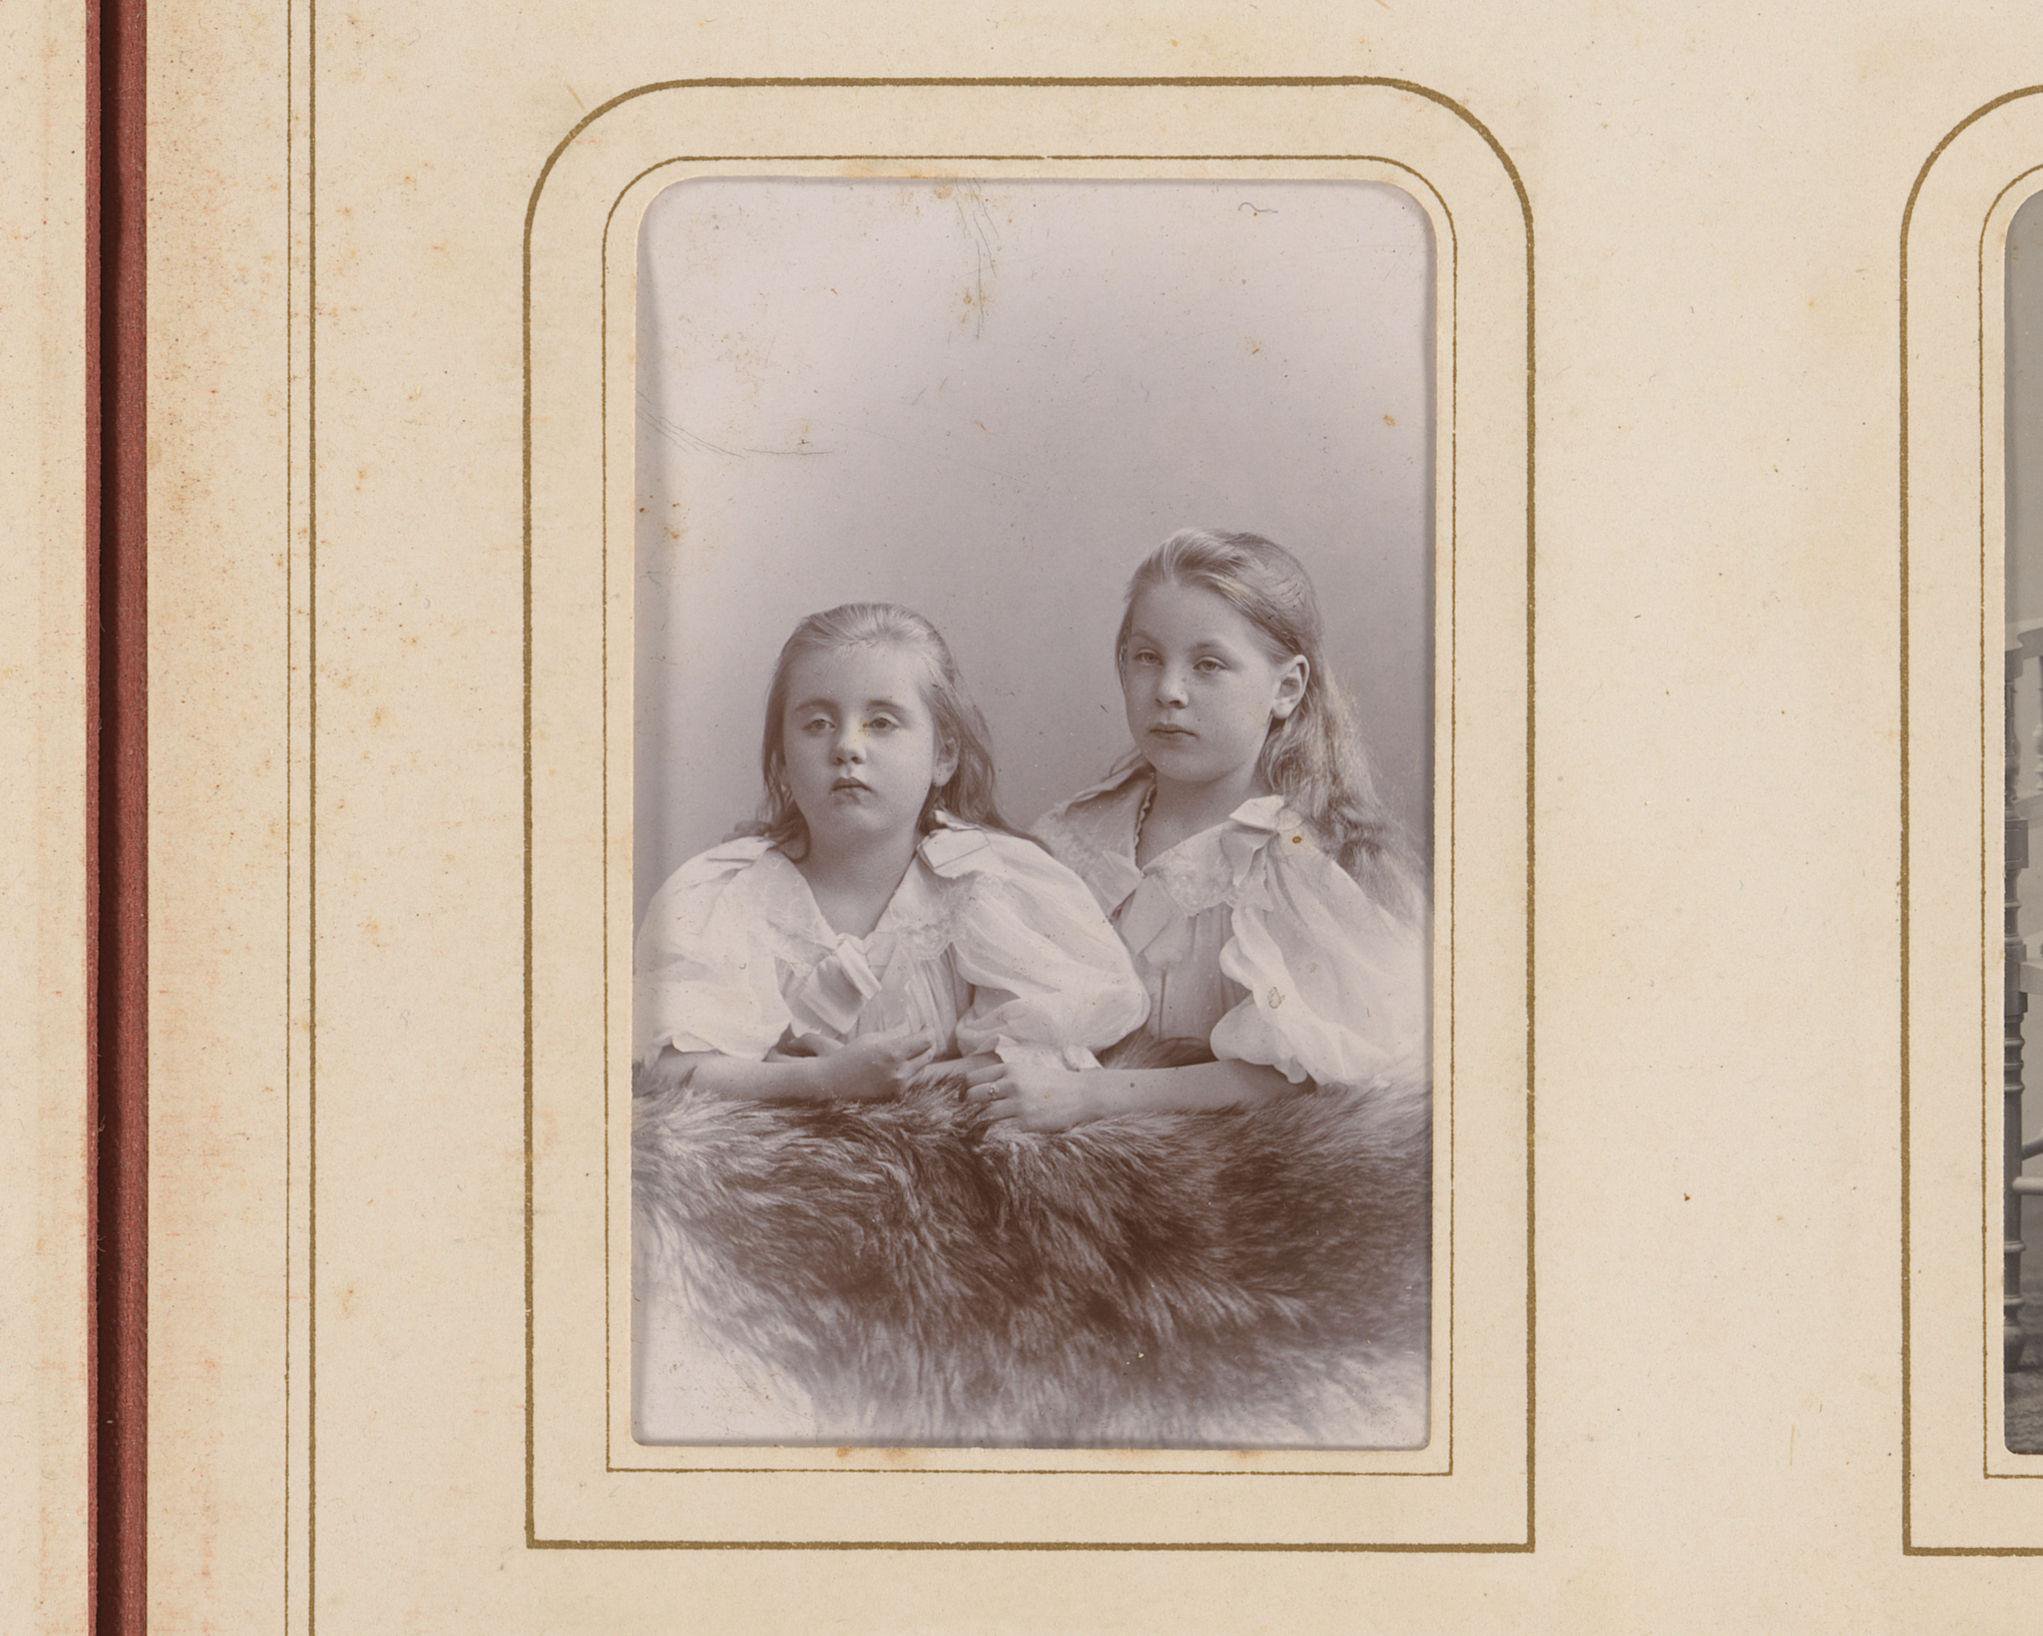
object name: carte de visite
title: Portret van twee jonge meisjes, aangeduid als Carla en Wanda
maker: p. schiffer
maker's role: fotograaf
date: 1898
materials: cardboard, photographic support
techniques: collodion silver print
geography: krefeld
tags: historical persons - bb - woman, girl (child between toddler and youth) (+ two persons)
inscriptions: inscription: ‘P. Schiffer/ Neue Linnerstrasse 74/ CREFELD./ Die Platte wird zum Nachbestellen/ aufbewahrt.’, annotation: ‘Carla en Wanda./ Nieuwjaar 1898.’